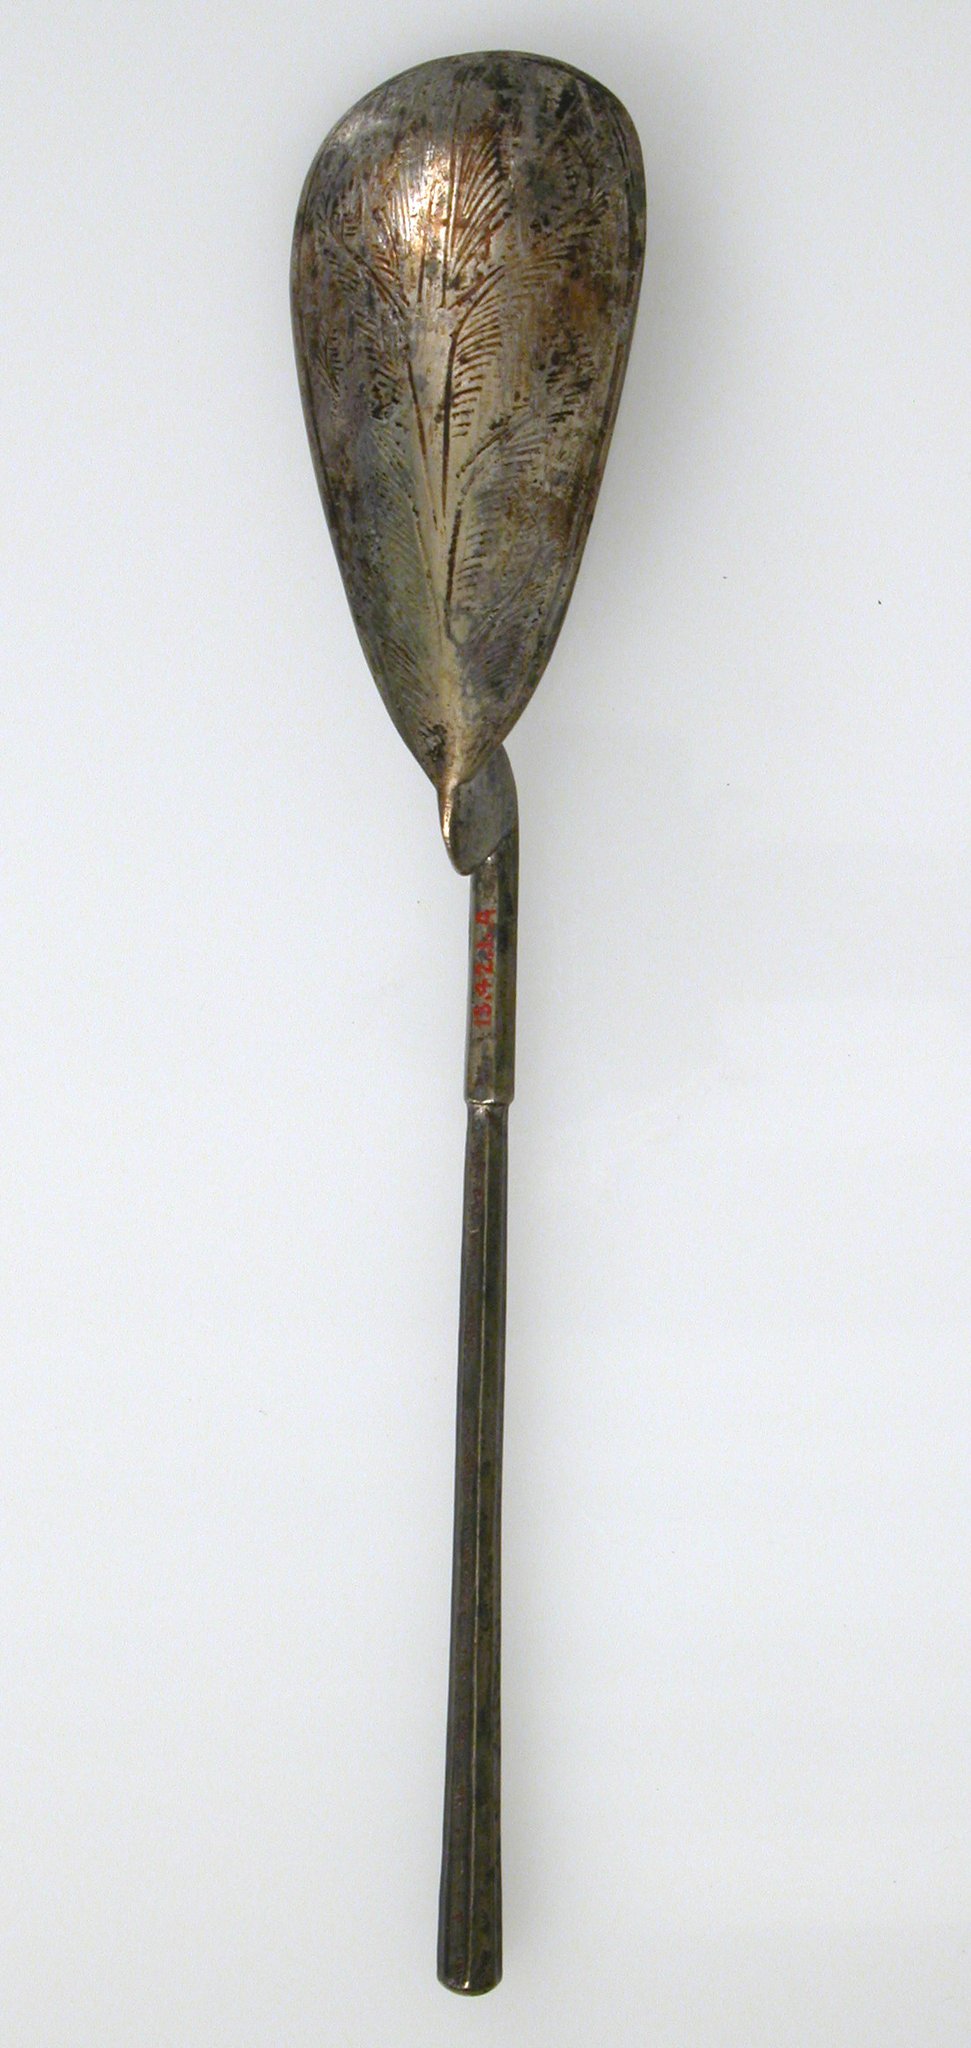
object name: spoon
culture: byzantine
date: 401-600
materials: silver